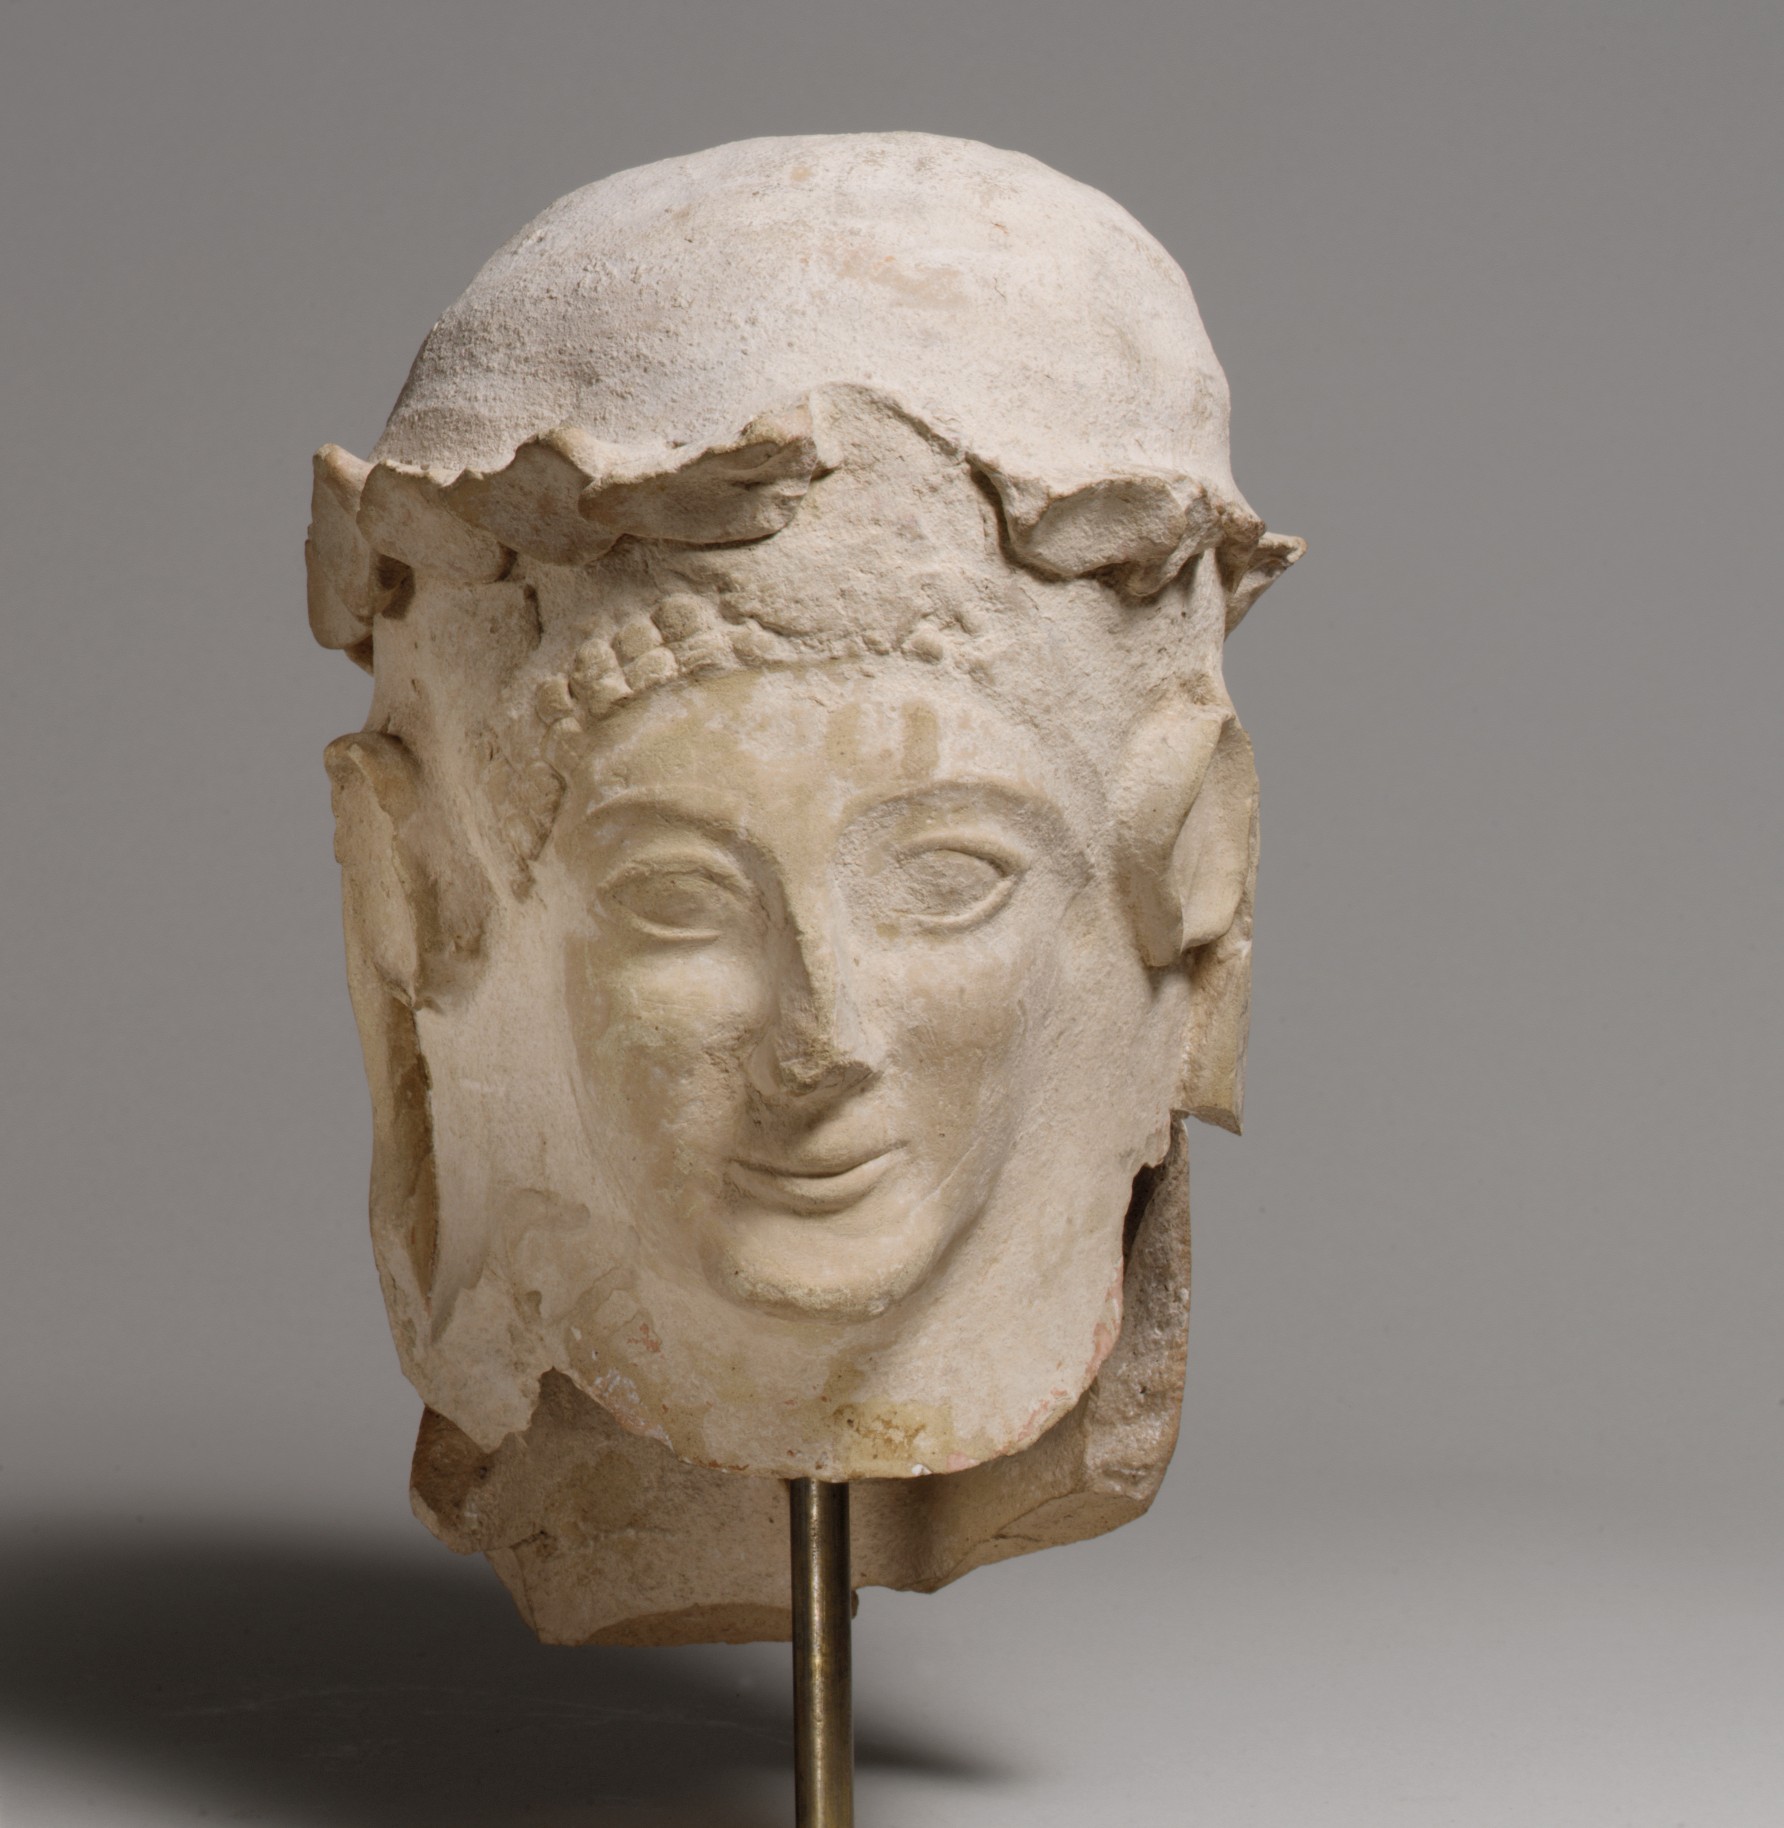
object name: head with wreath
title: Terracotta head with wreath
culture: cypriot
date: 600-480 BCE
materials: terracotta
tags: heads,wreaths